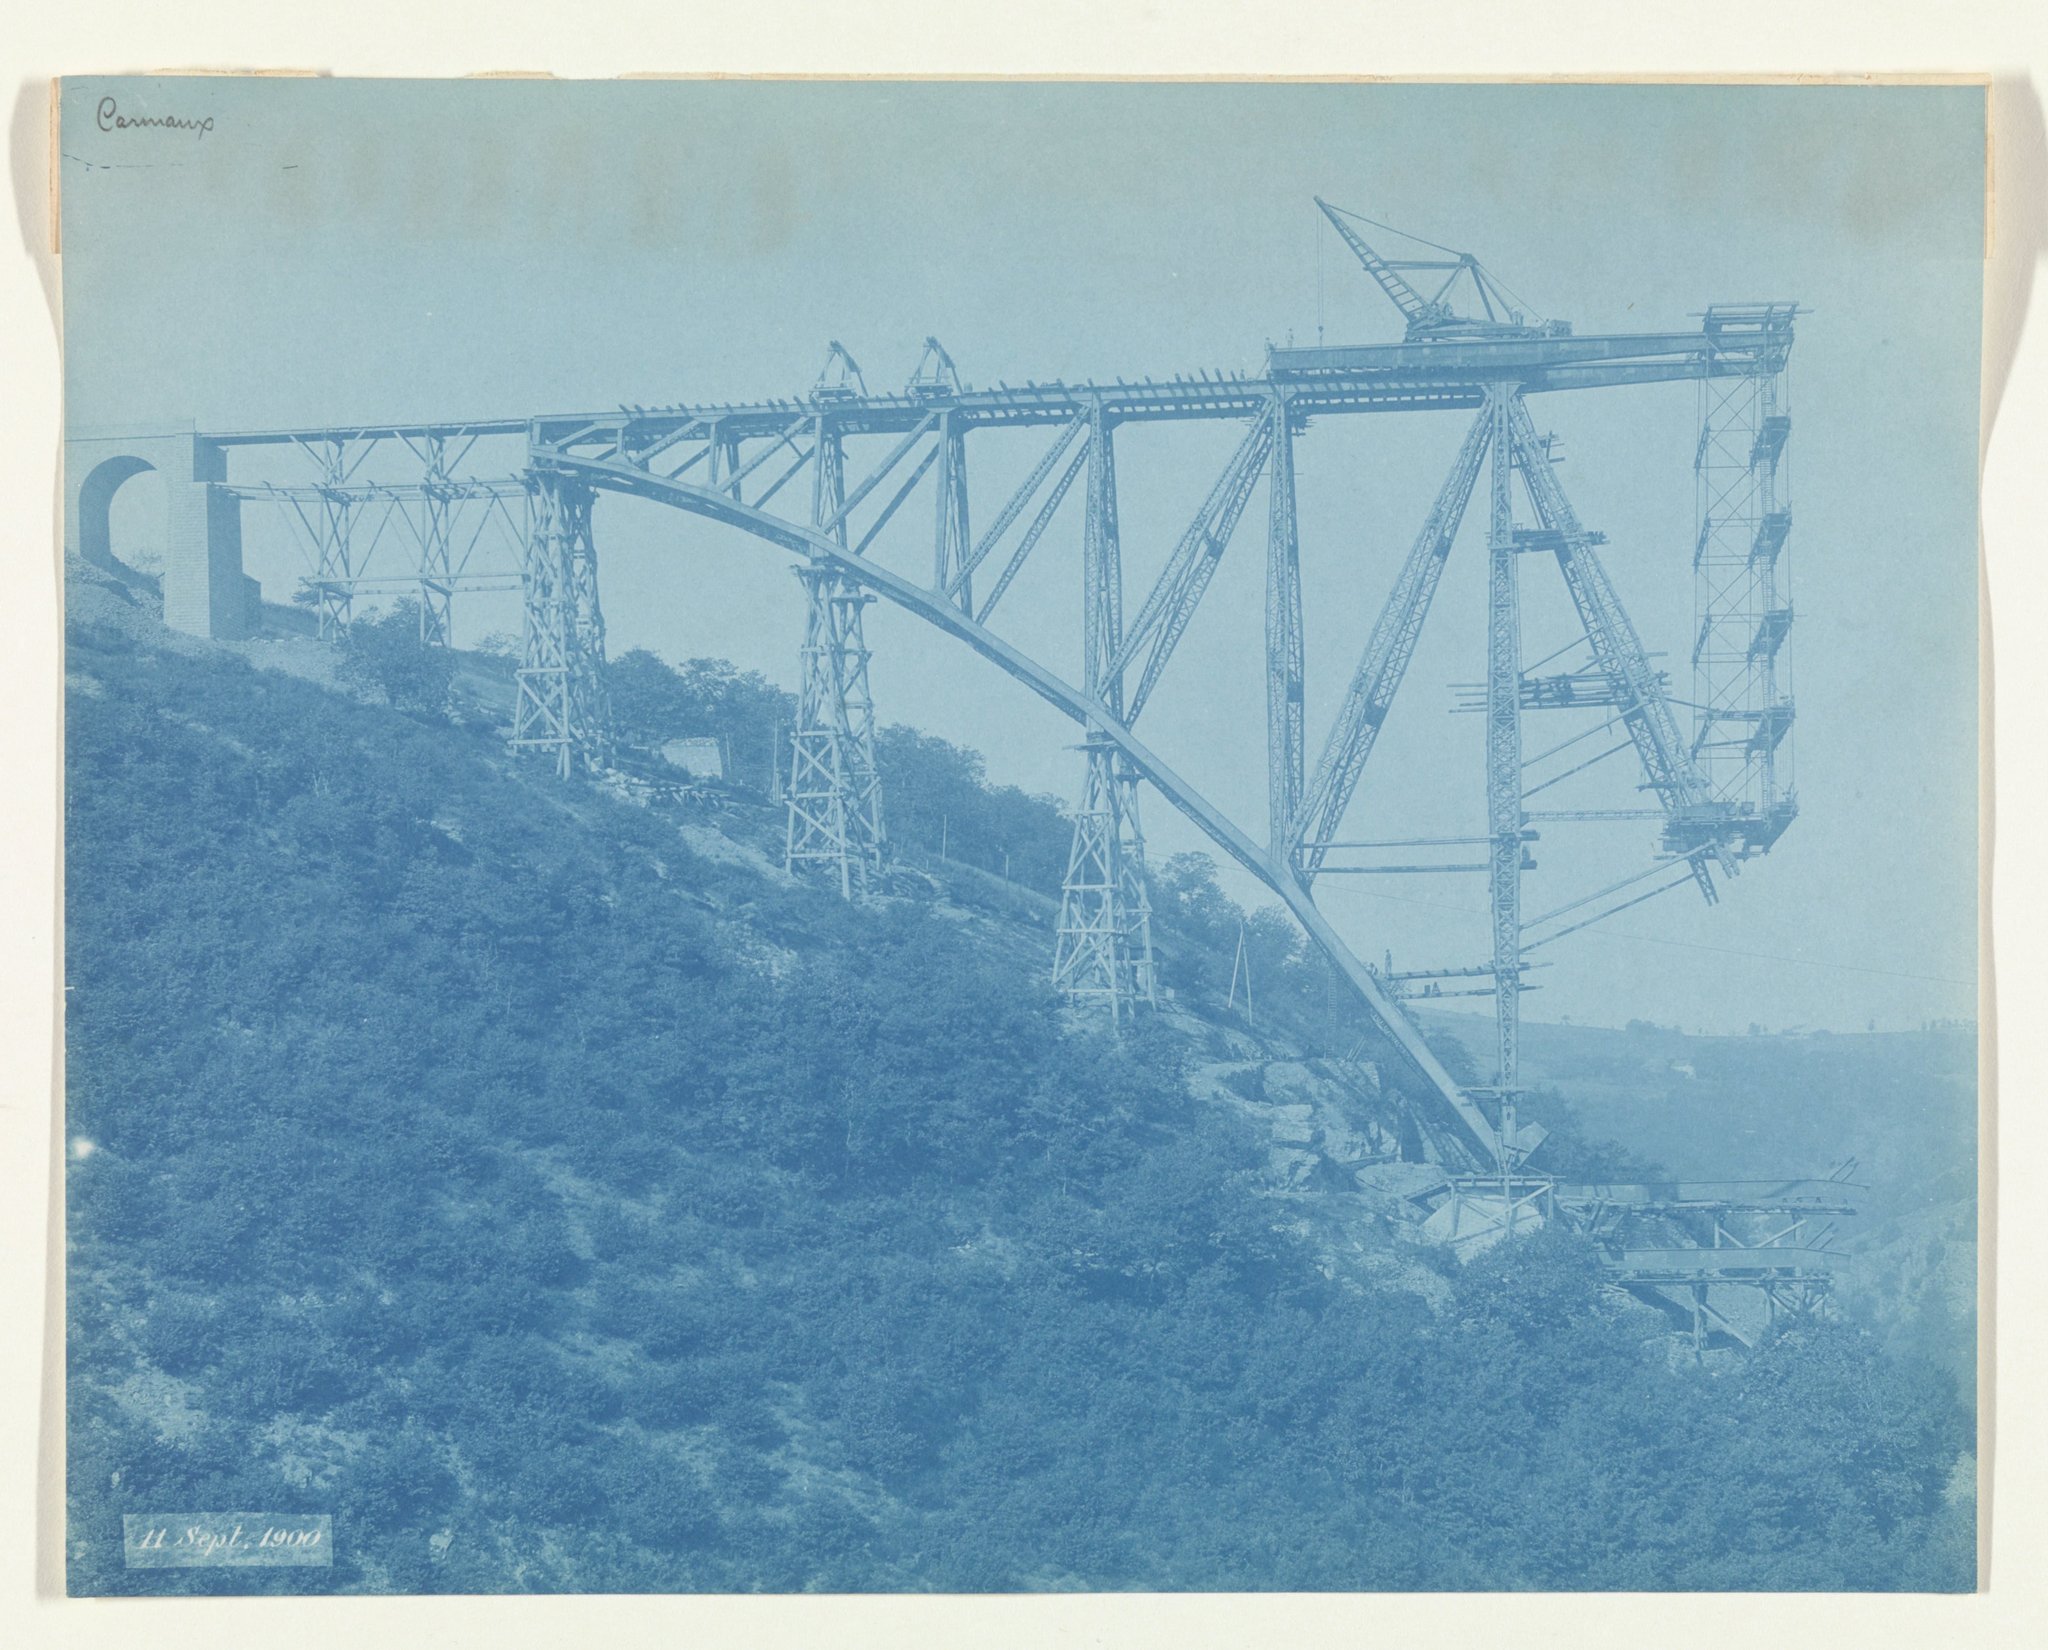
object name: photograph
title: Aanleg van het Viaur Viaduct in Frankrijk door de Societé de Construction des Battignolles, 11 september 1900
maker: Anonymous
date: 1900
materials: photographic support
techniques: cyanotype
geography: france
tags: viaduct, making the overground structures (~ building activities)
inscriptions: inscription: ‘Carmaux’